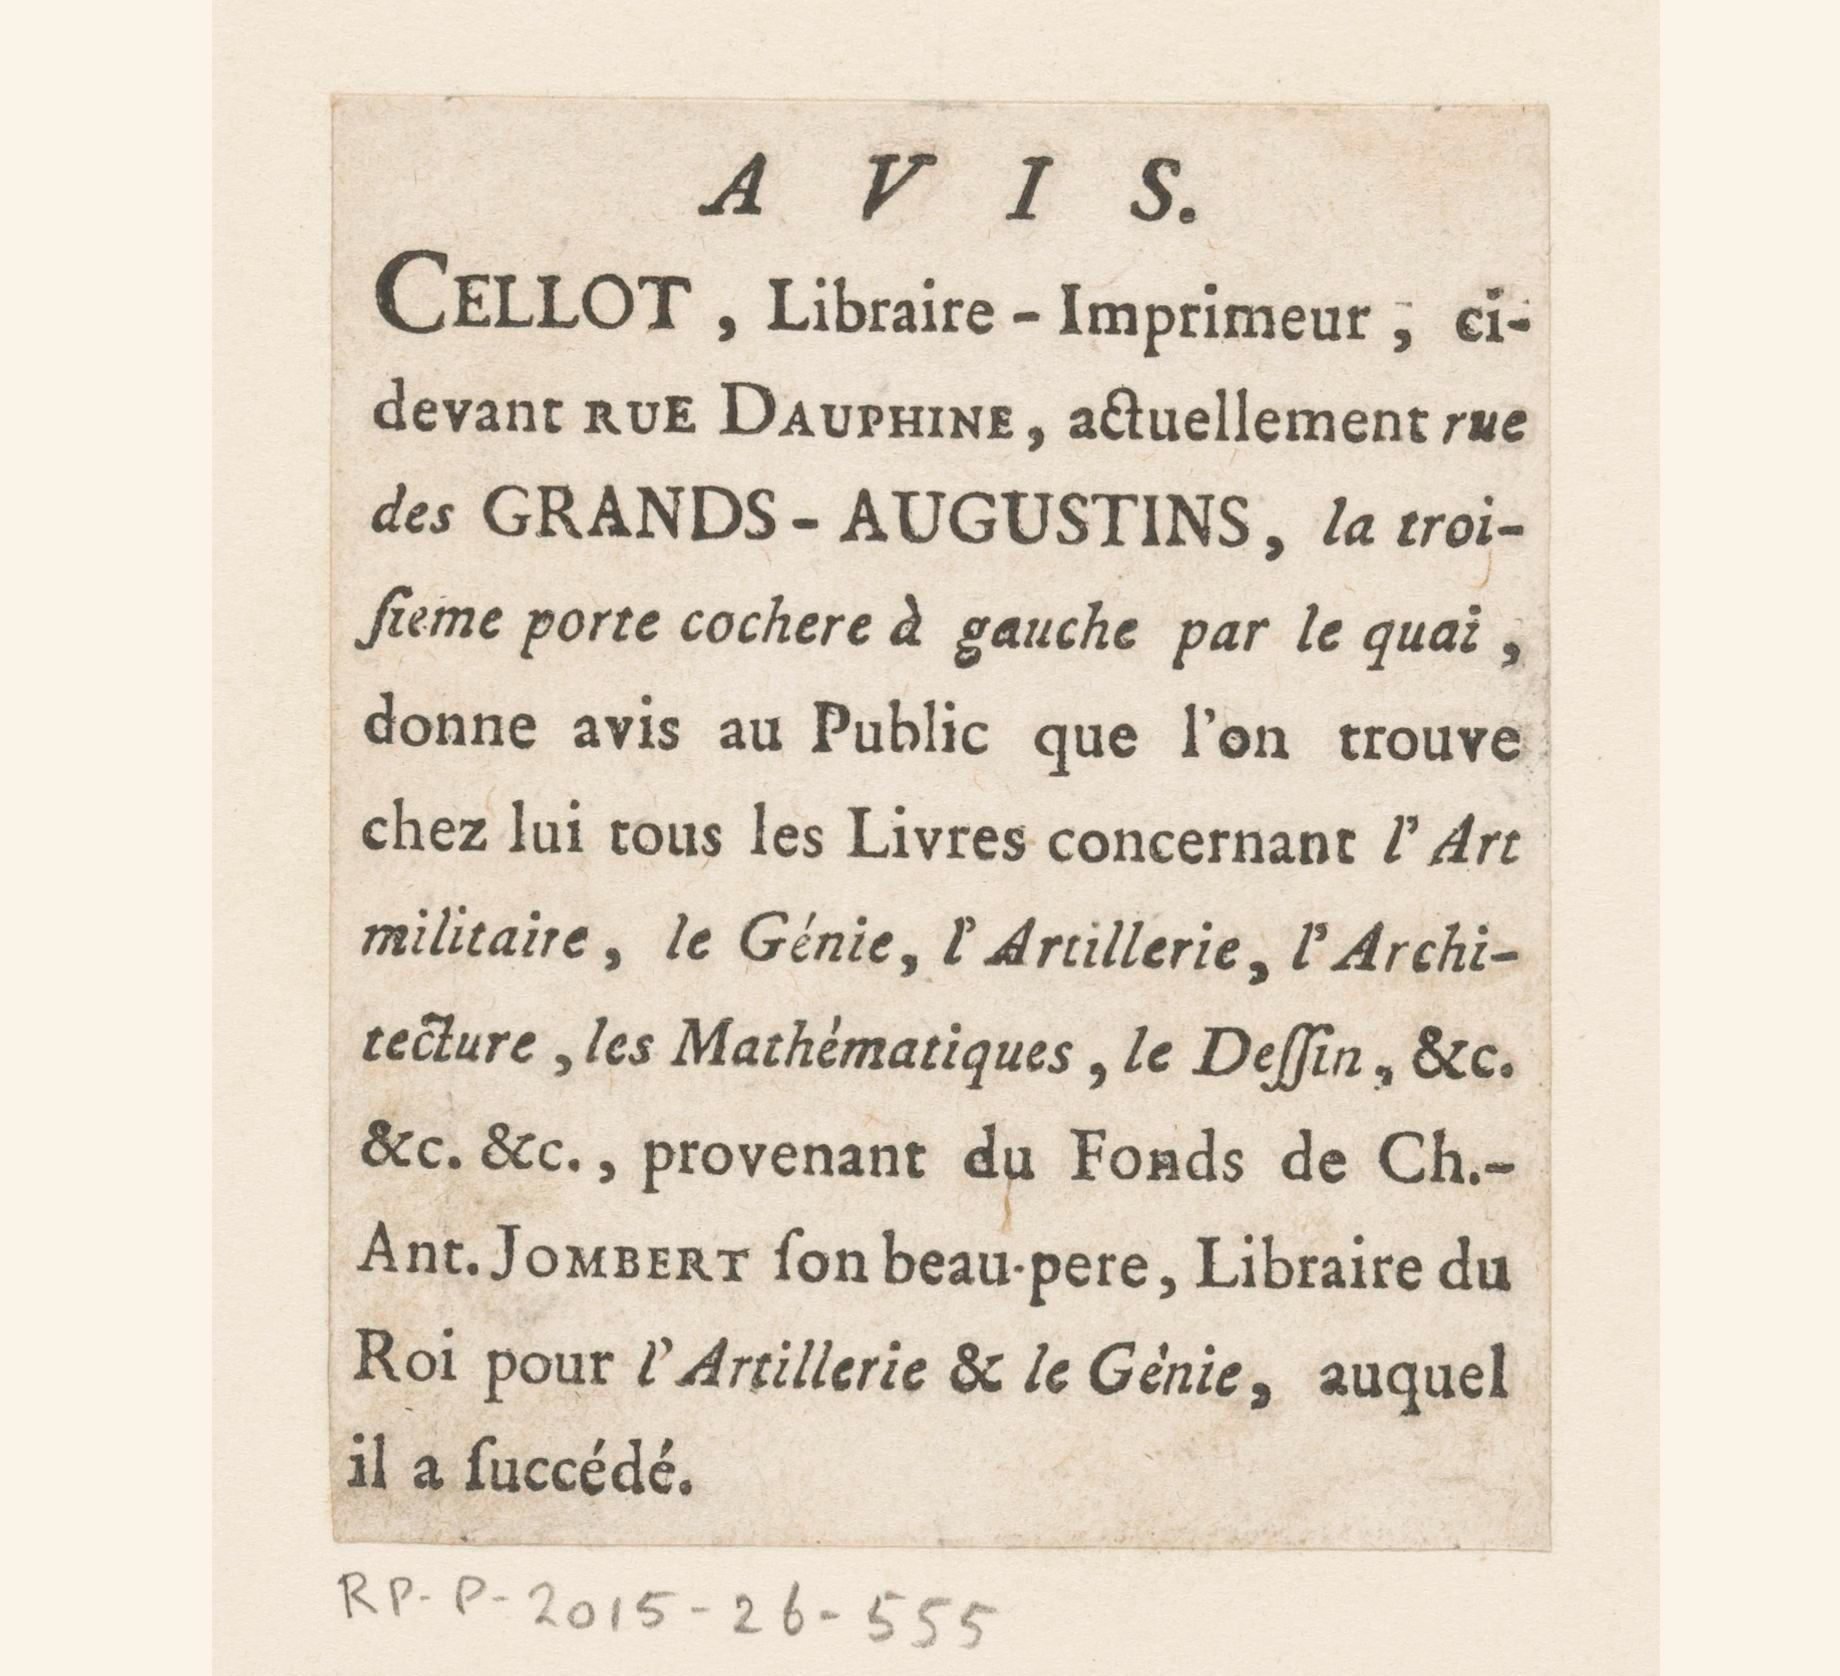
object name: print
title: Aankondiging van boekhandelaar Louis Cellot te Parijs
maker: louis cellot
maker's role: publisher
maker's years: 1731-1815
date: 1756-1815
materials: paper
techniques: letterpress printing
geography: paris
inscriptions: collector's mark: Lugt 2228